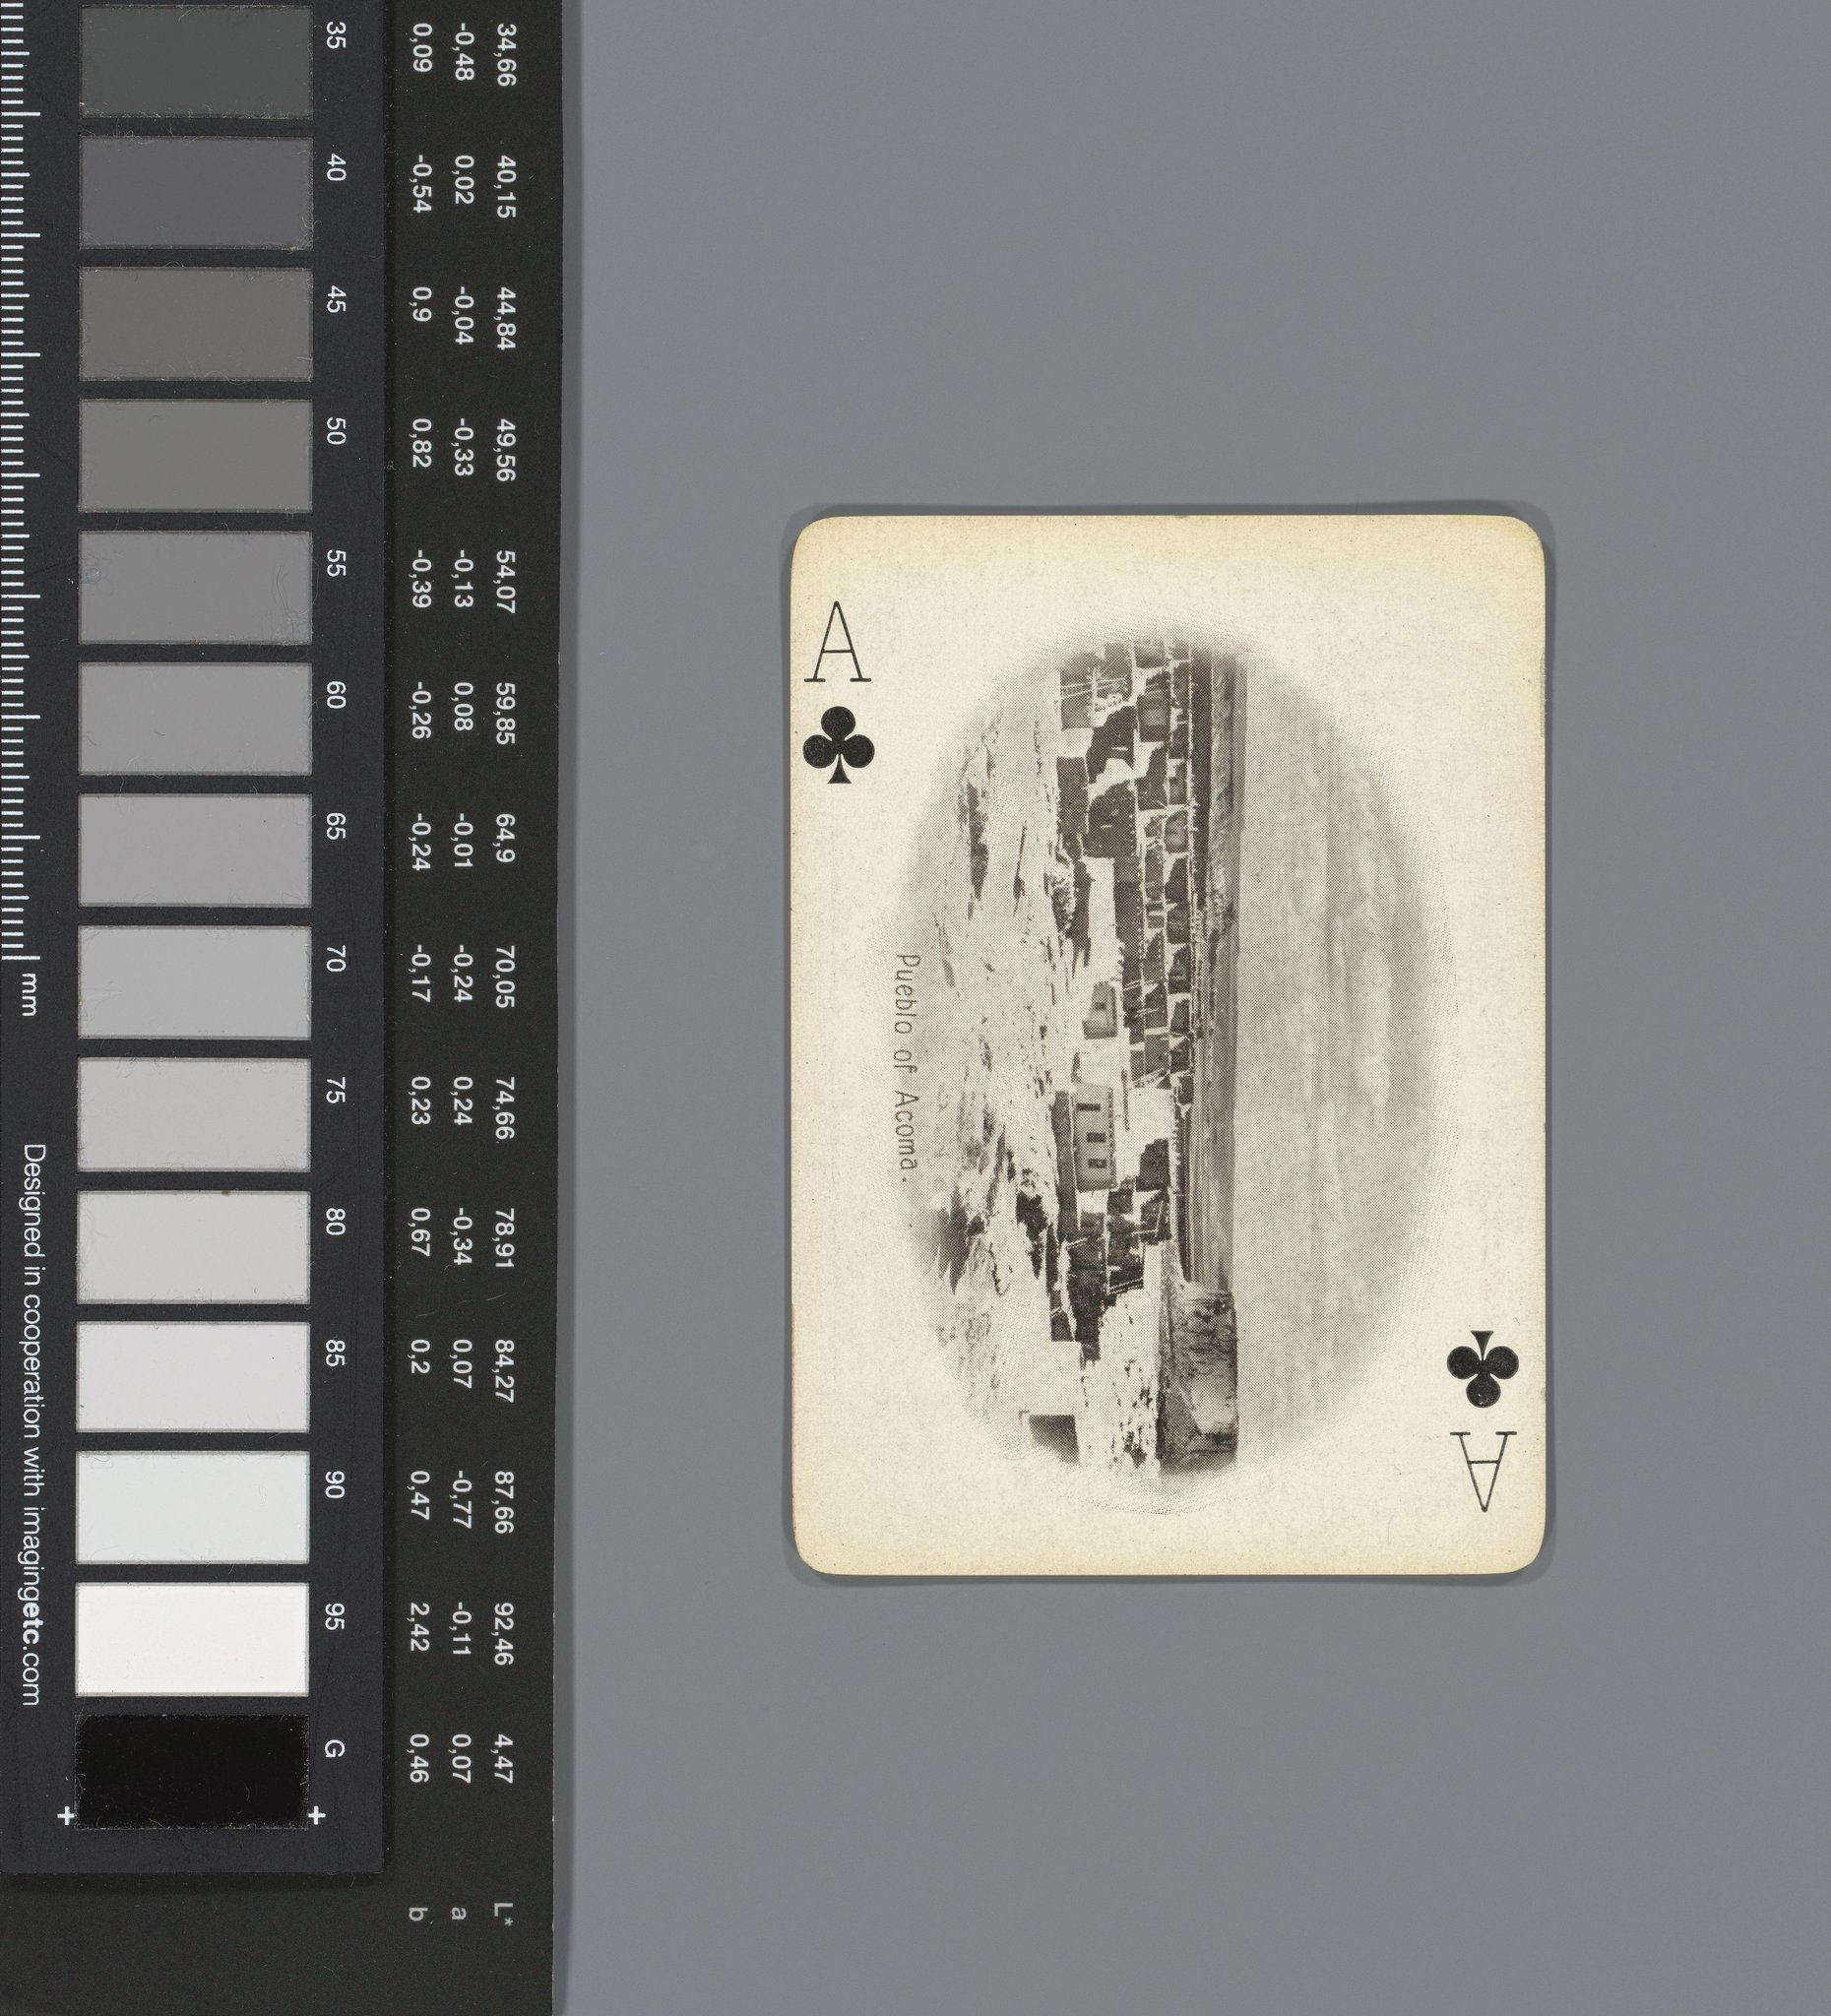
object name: playing card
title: Klaver aas met gezicht op Acoma Pueblo, New Mexico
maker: adam clark vroman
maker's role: fotograaf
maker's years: 1856-1916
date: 1900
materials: paper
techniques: autotype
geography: los angeles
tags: united states of america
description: Speelkaart uit doosje met 53 speelkaarten met afbeeldingen in autotypie van Native Americans. De inhoud bevat een complete set speelkaarten inclusief joker.